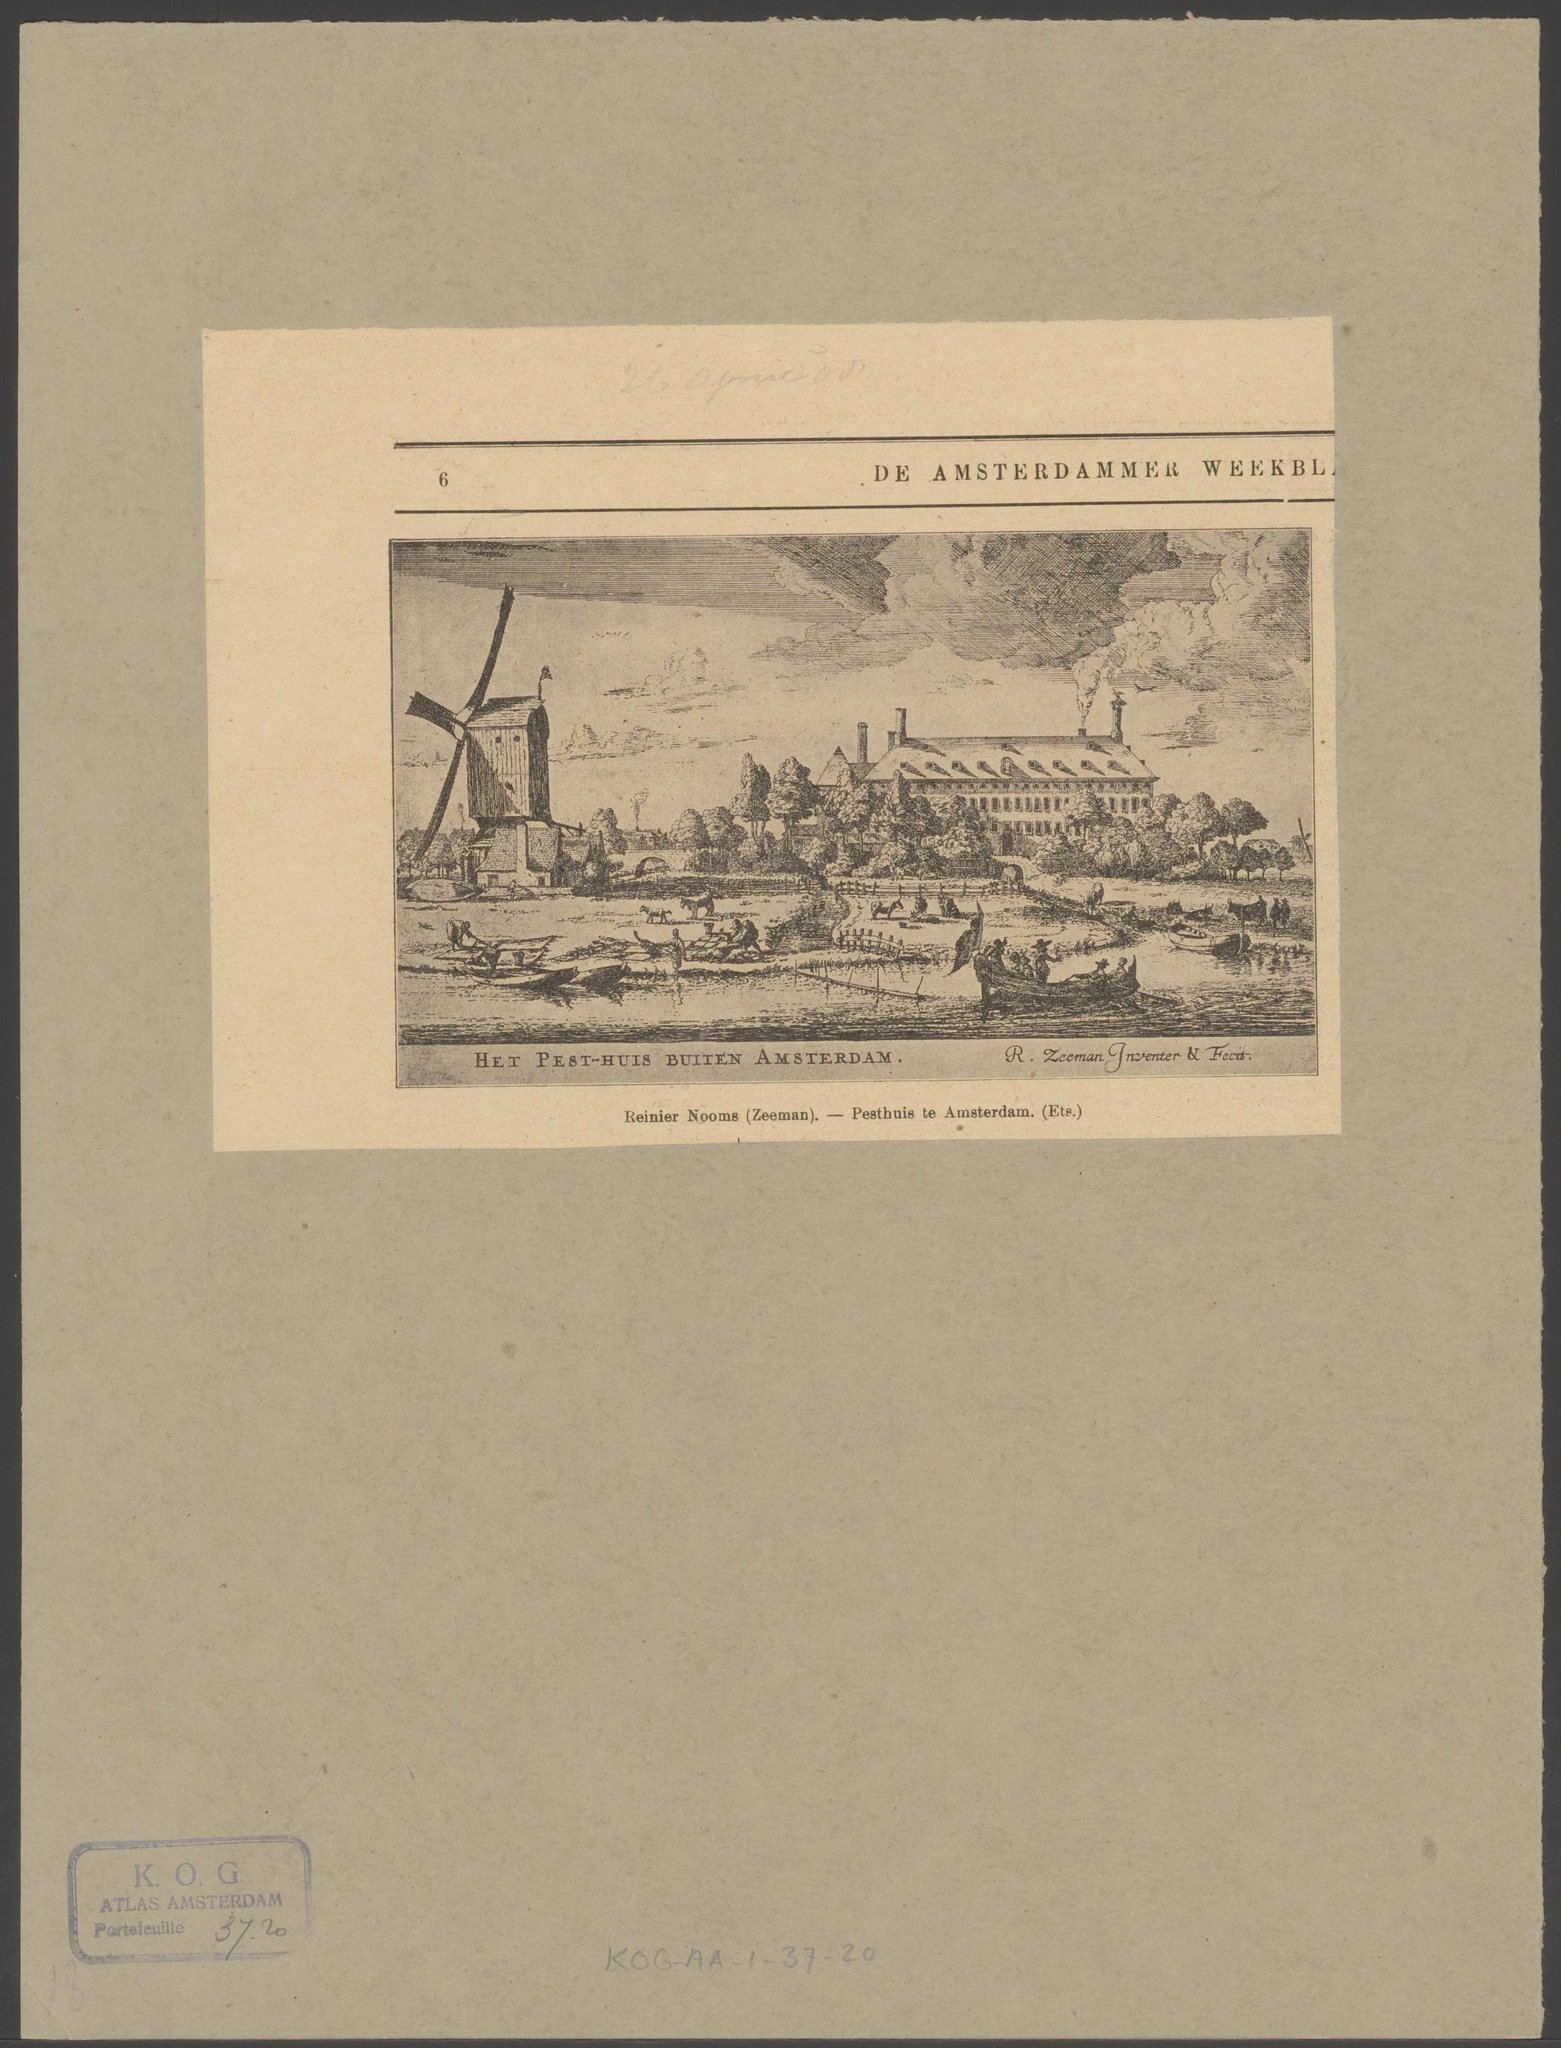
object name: photomechanical print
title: Het Pest-huis buiten Amsterdam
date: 1908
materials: paper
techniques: letterpress printing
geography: amsterdam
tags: rowing-boat, canoe, etc., windmill in landscape, hospital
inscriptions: collector's mark: Lugt 1641b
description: Onderwerpsrubriek binnen de Atlas Amsterdam: Armwezen en liefdadige instellingen: I. Stadsinrichtingen: Buitengasthuis (Pesthuis).